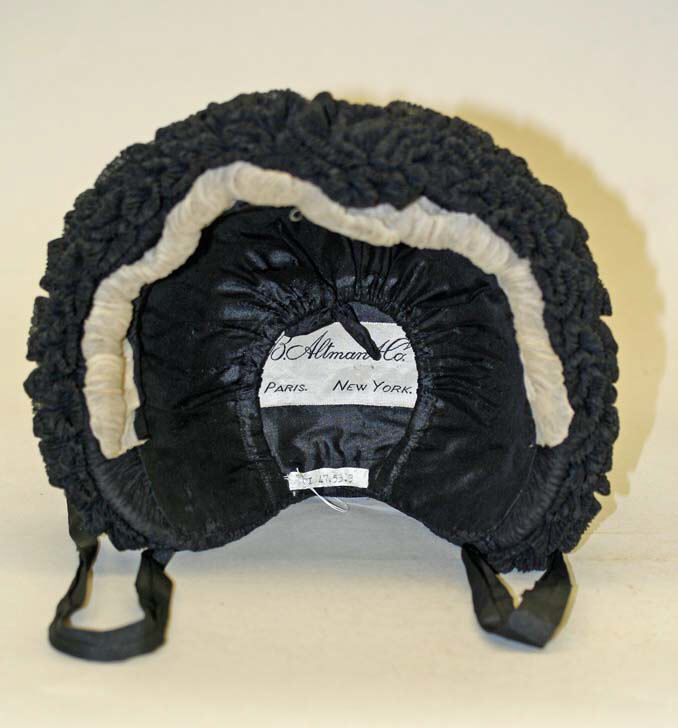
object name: mourning bonnet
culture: american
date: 1870-1879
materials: silk